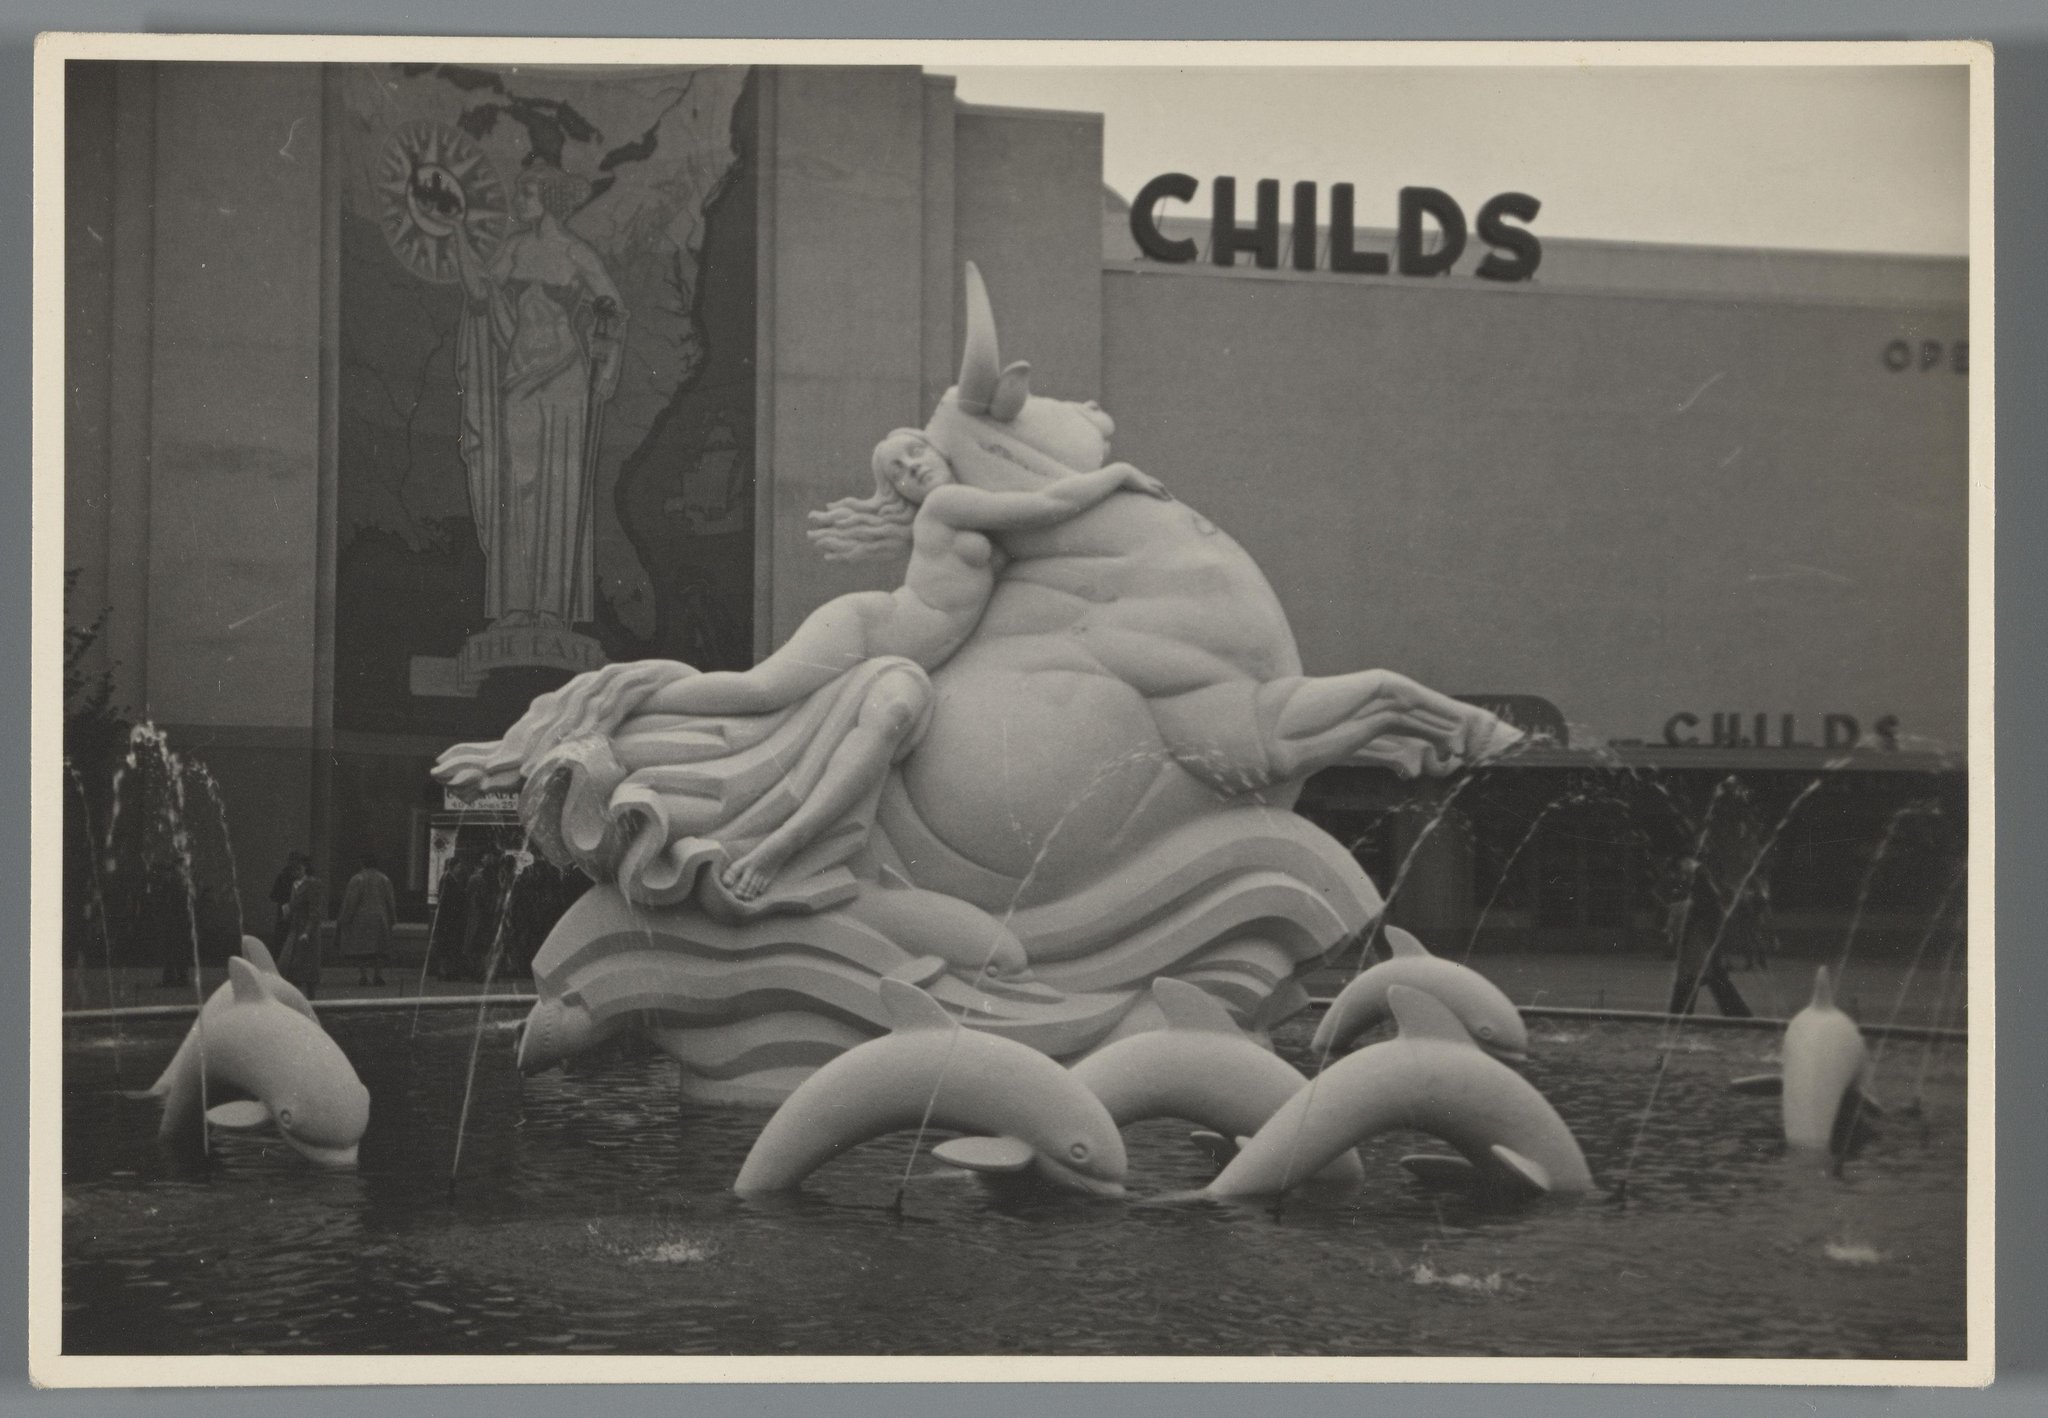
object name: photograph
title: Beeldhouwwerk Europa door Gleb Derujinsky op de World Fair, voor het Childs restaurant New York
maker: Anonymous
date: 1939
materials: photographic support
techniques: gelatin silver print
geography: new york city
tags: new york (city)